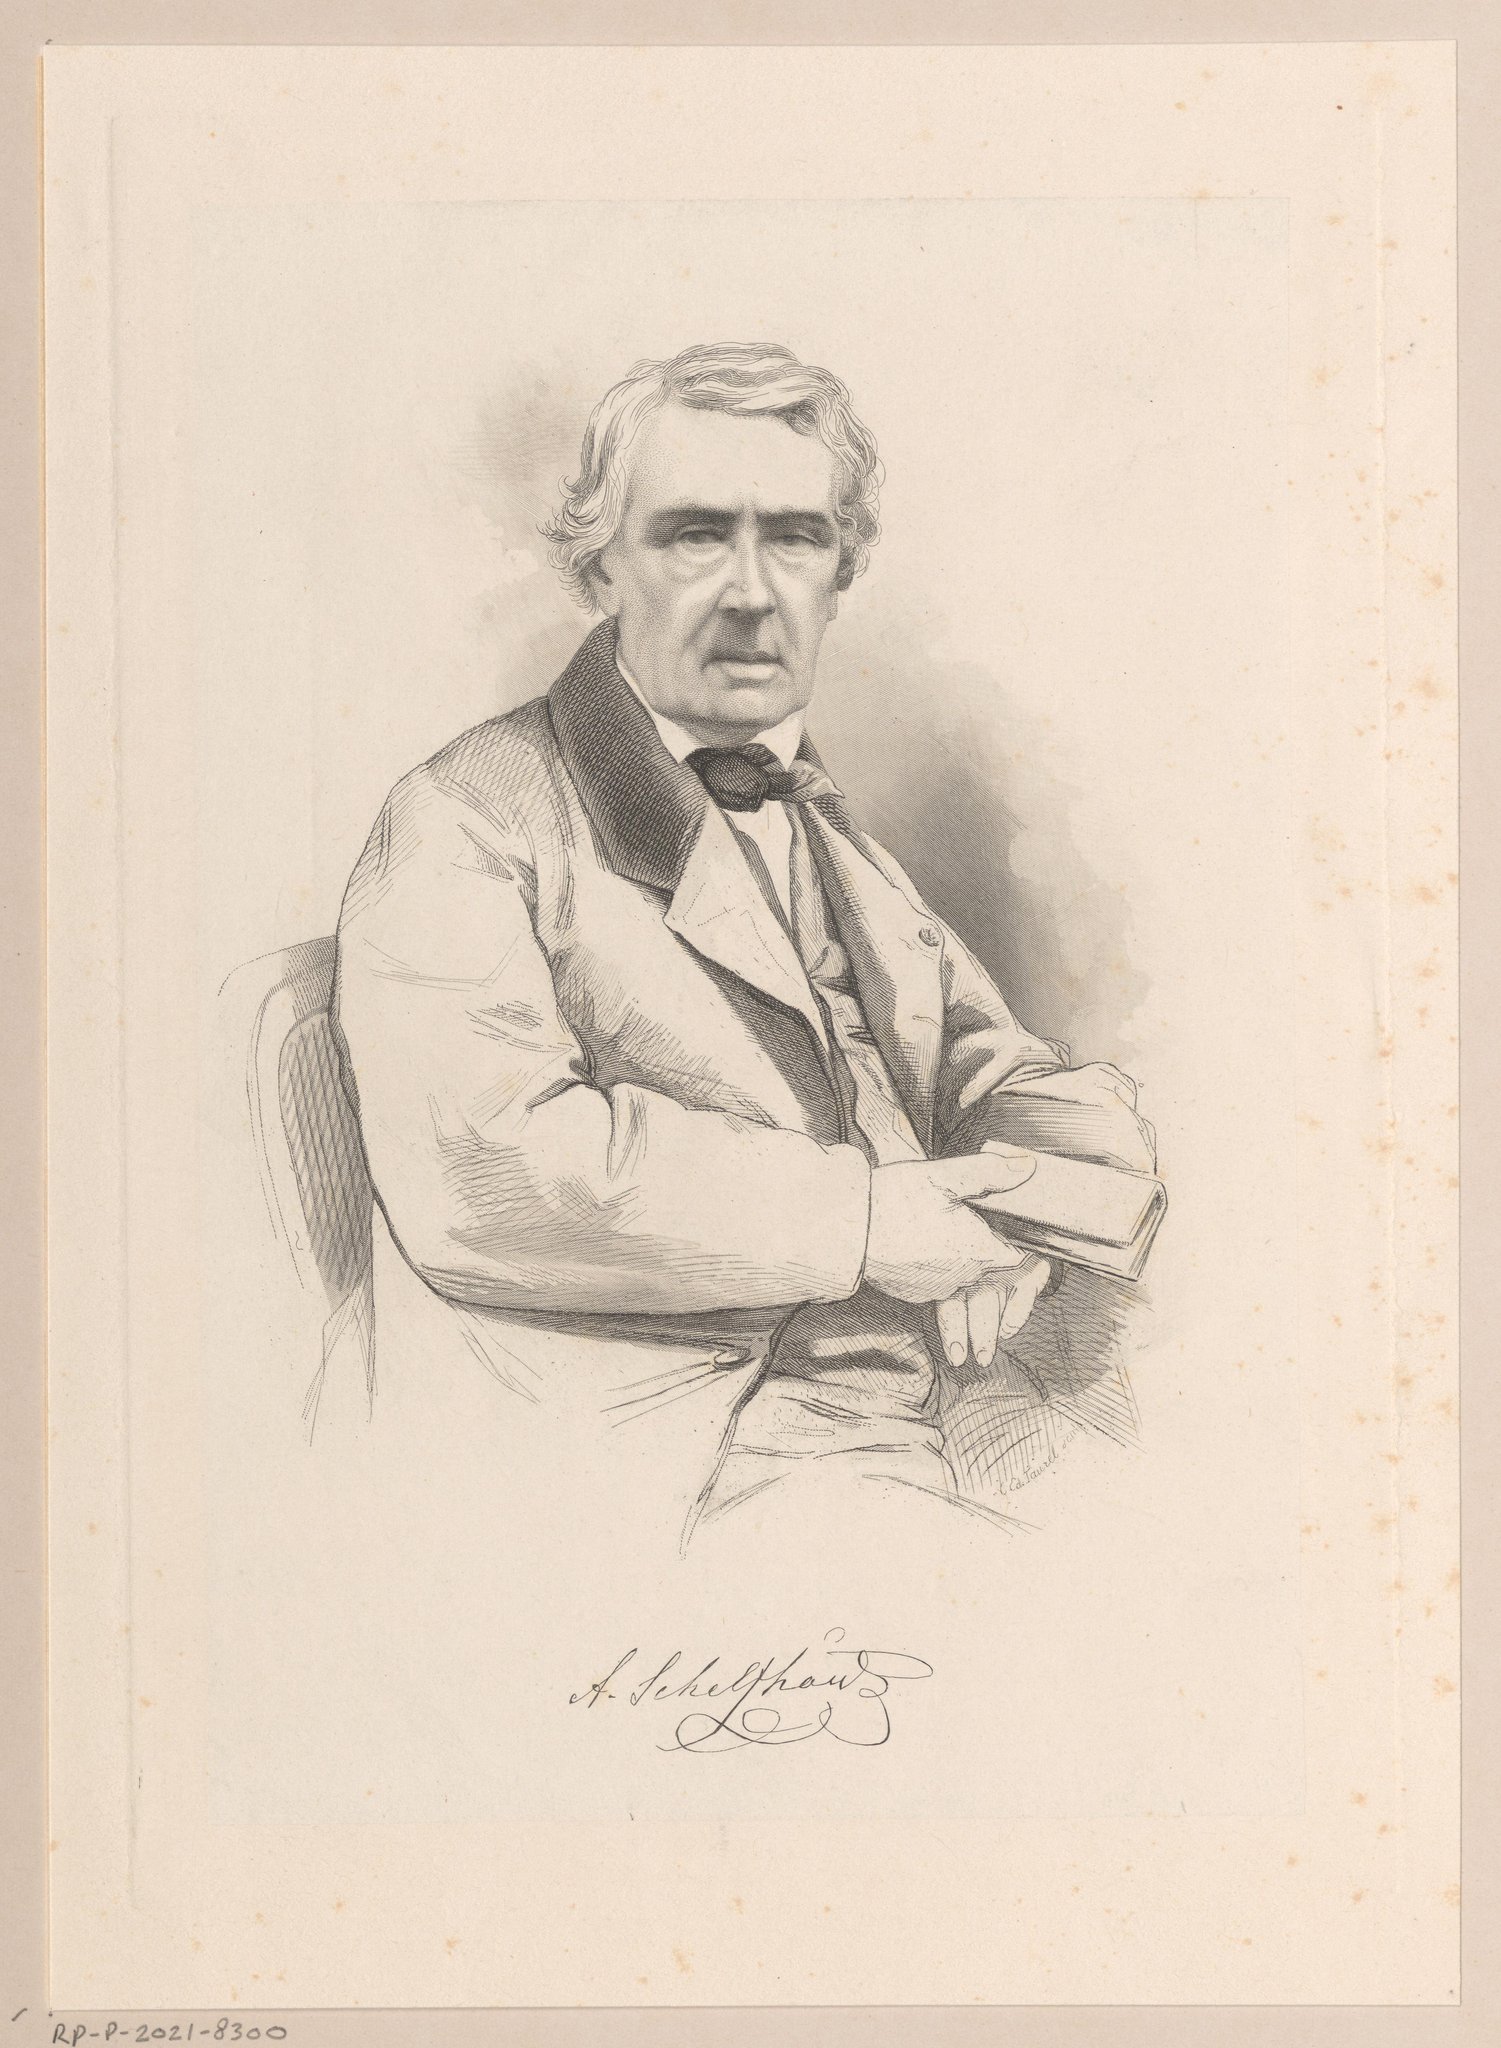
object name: print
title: Portret van Andreas Schelfhout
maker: edouard taurel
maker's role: draughtsman, print maker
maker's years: 1824-1892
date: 1867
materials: paper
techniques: engraving, etching, roulette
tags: print maker, andreas schelfhout, historical persons, portrait, self-portrait of painter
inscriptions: collector's mark: Lugt 964, inscription: ‘April: 89’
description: Prent waarschijnlijk uit: Kunstkronijk (...) 8 (1867).